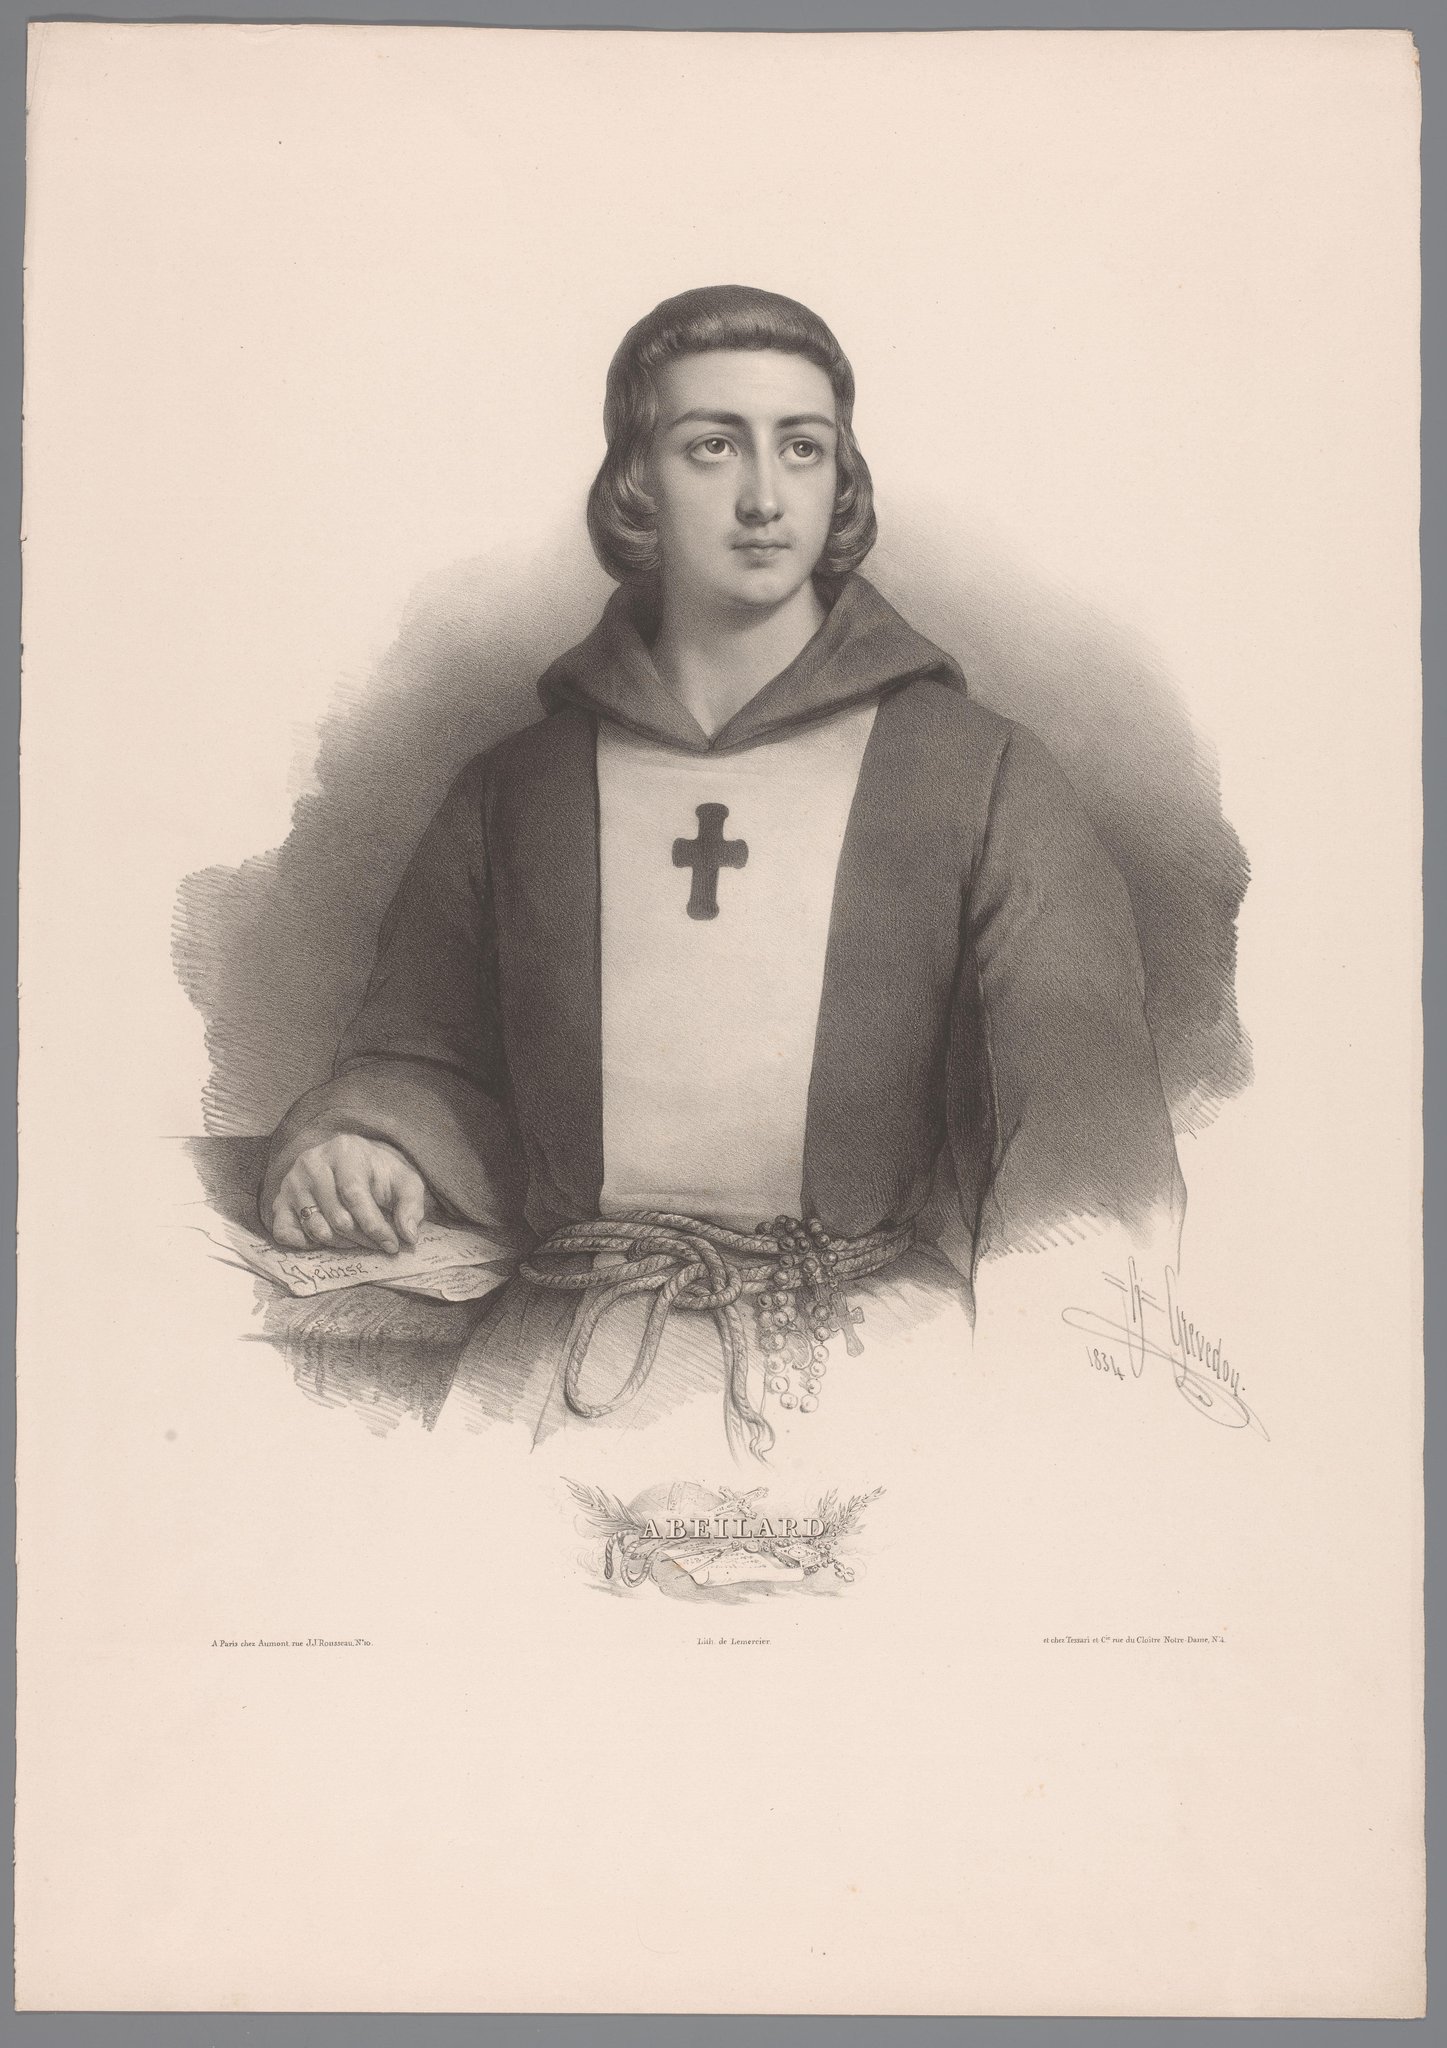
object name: print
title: Portret van Pierre Abélard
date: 1834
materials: paper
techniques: lithograph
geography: paris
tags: historical persons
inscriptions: collector's mark: Lugt 2228a